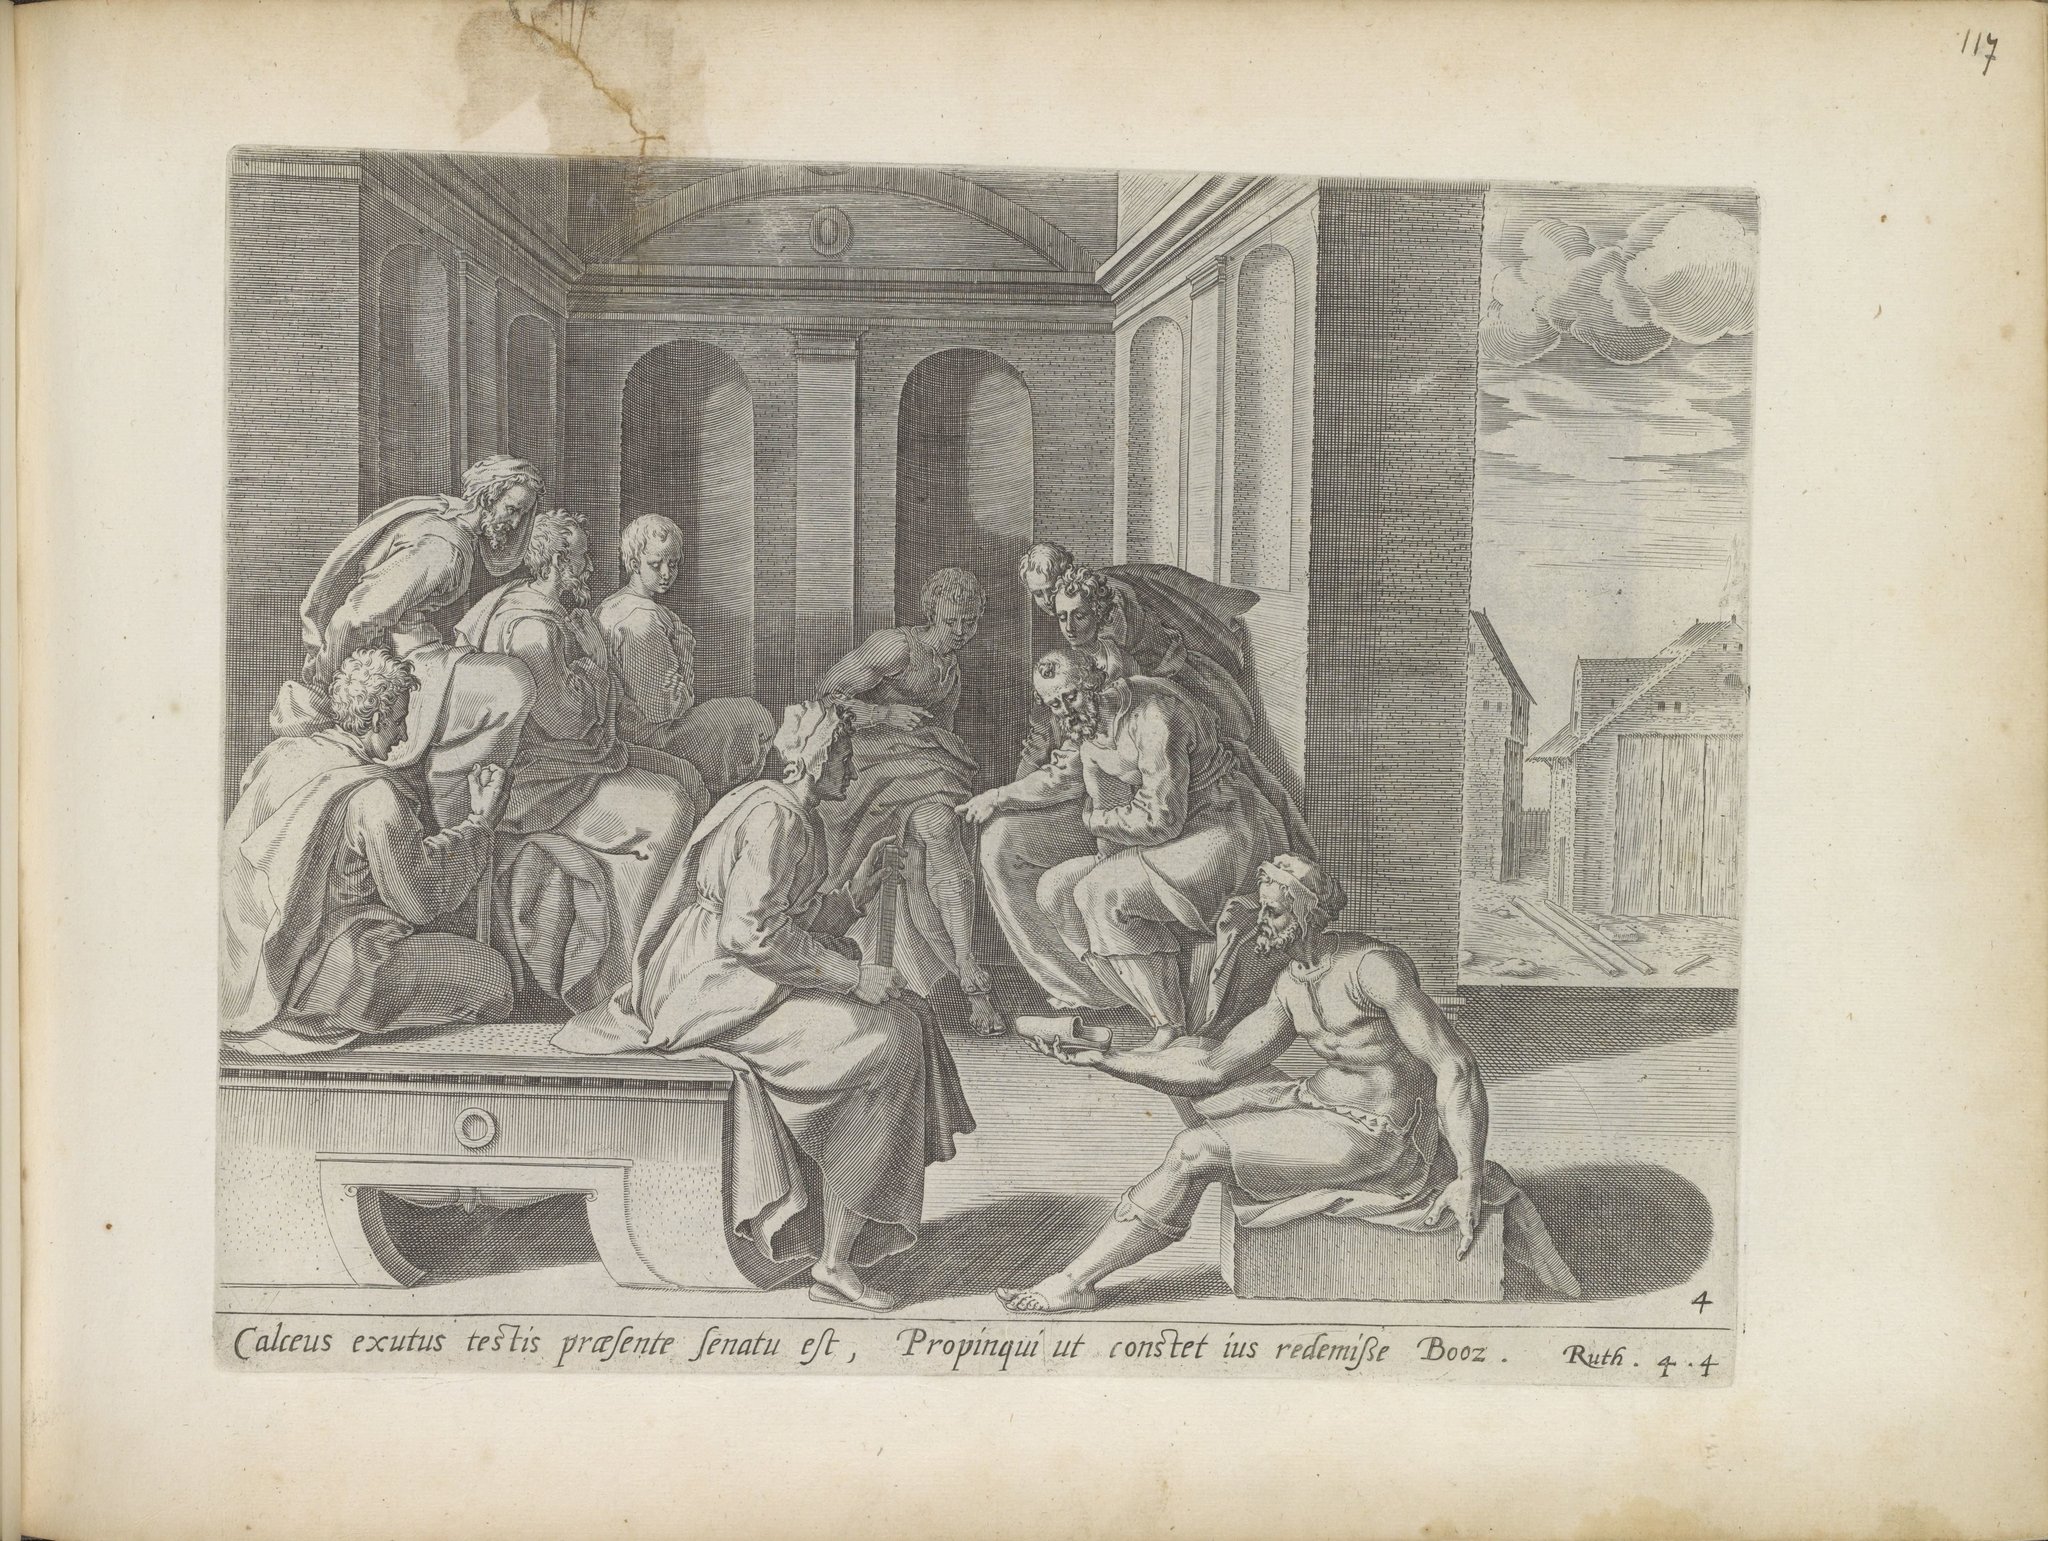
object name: album leaf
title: Boaz koopt het land van Ruth en Naomi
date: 1579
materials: paper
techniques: engraving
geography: amsterdam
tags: elimelech's kinsman cannot redeem it; he takes off his shoe, boaz redeems elimelech's inheritance (ruth 4:1-12)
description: Boaz ontvangt bij de stadspoort de sandaal van een man die net als Boaz het recht heeft om het land van Ruth en Naomi te kopen. De man toont hiermee dat hij zijn recht niet laat gelden. Een groep stadsoudsten is getuige van de koop en van Boaz' belofte om met Ruth te trouwen. Onder de voorstelling een verwijzing in het Latijn naar de Bijbeltekst in Ruth 4:4. Deze prent maakt deel uit van een album.